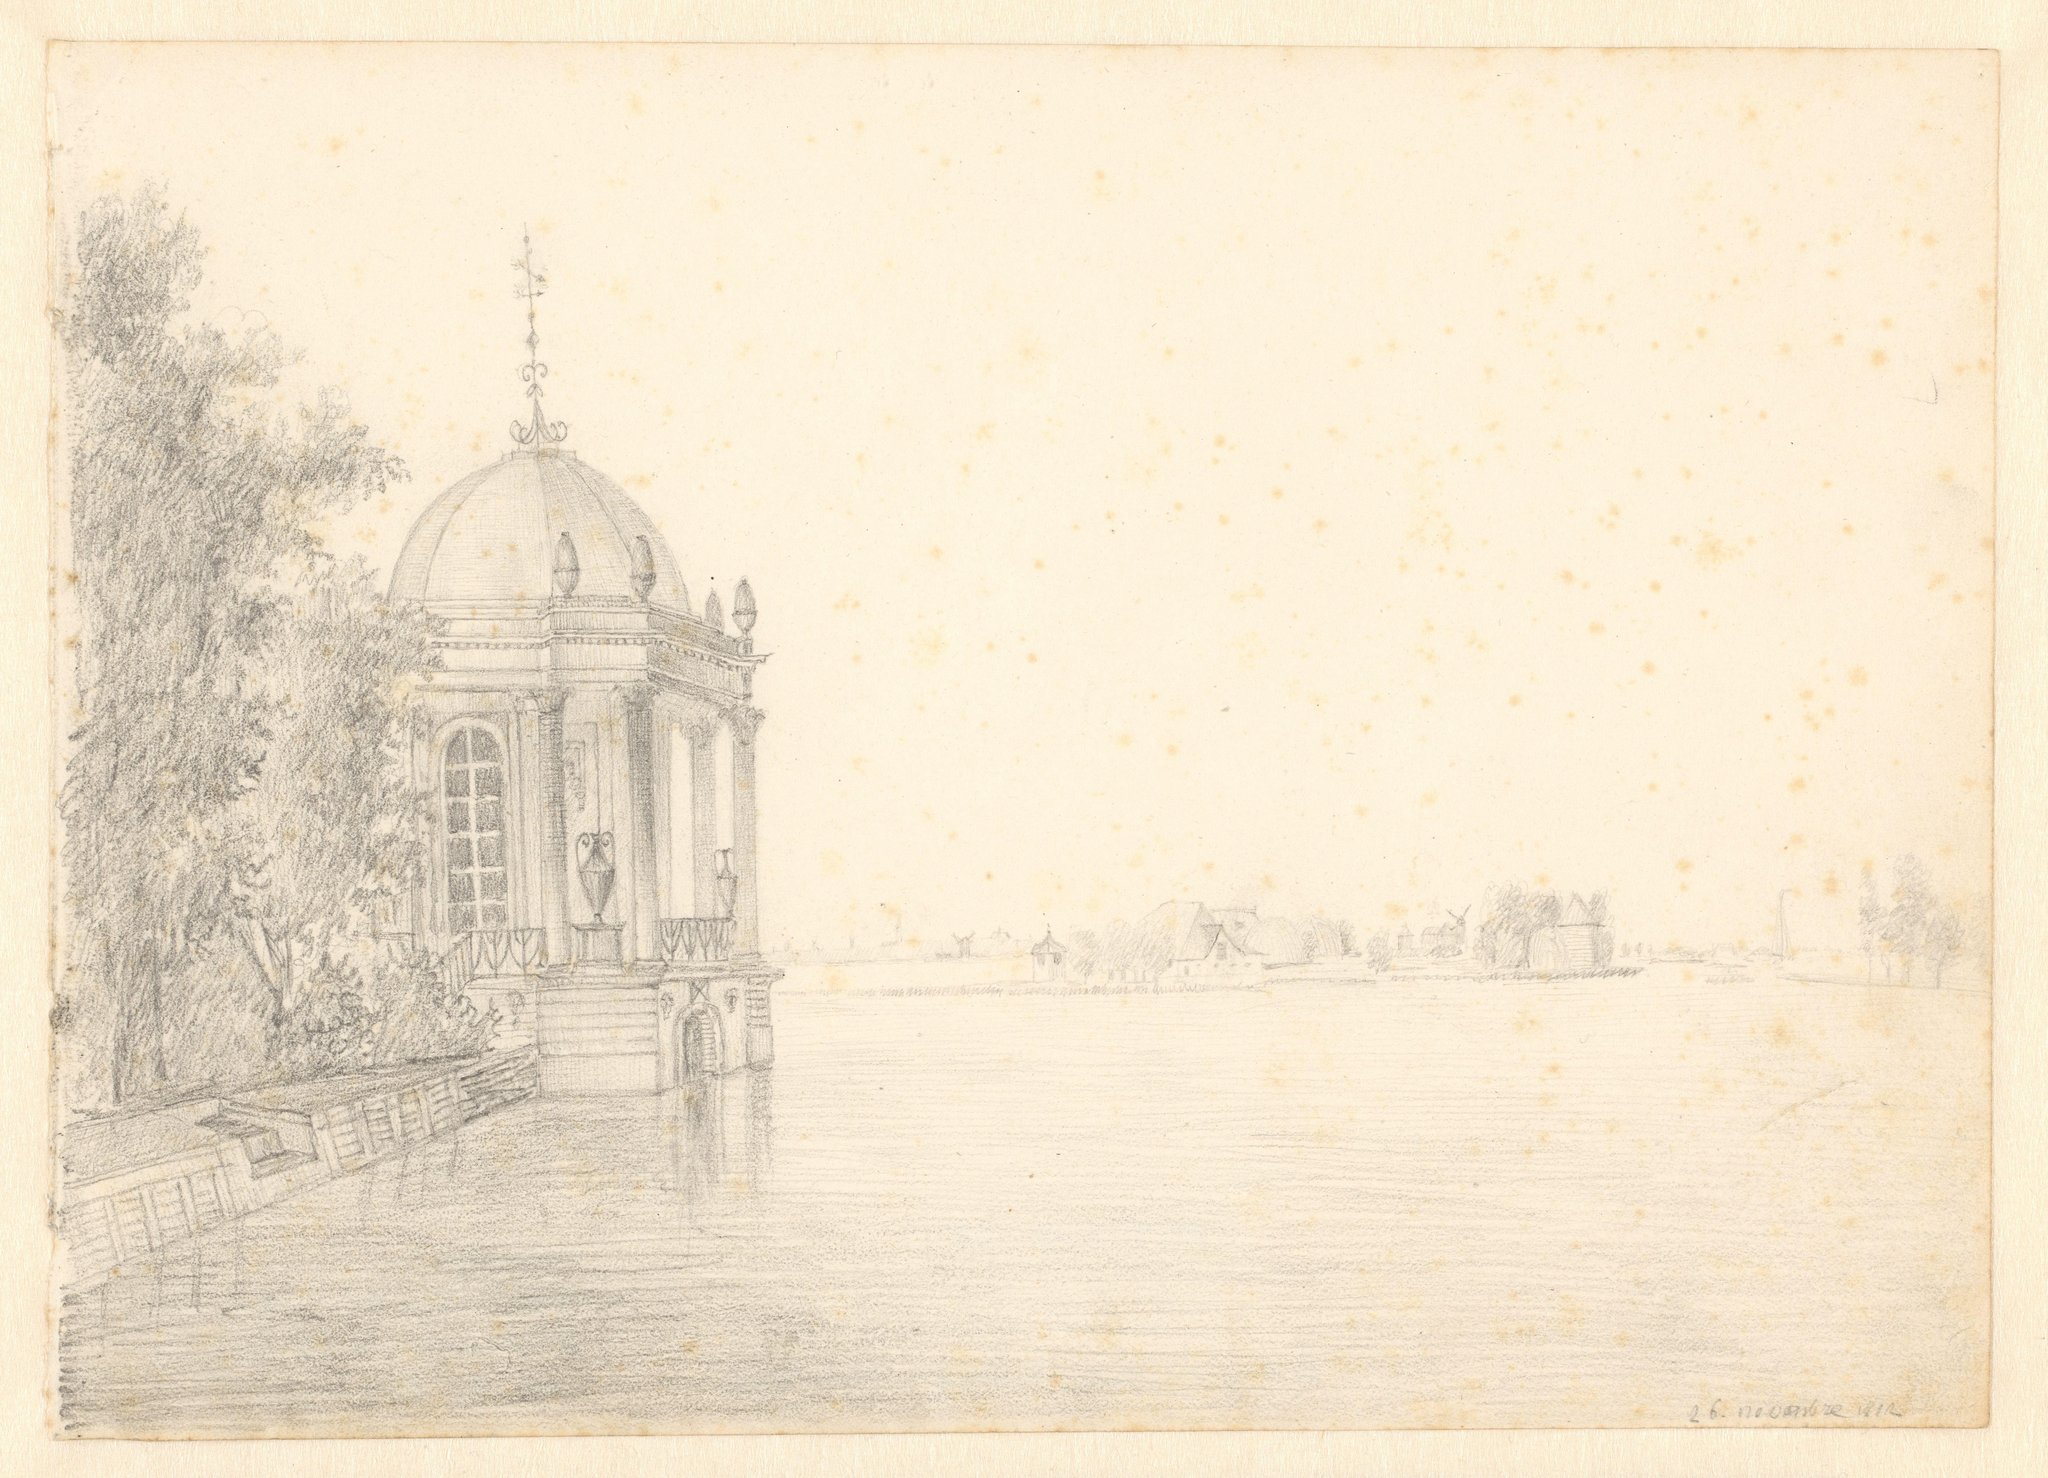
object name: drawing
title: Gezicht op Broek in Waterland met links de koepel van Bakker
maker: adèle clerget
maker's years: 1799-1841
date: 1812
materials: paper, pencil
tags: broek in waterland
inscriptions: date: ‘26. novembre 1812’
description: Detail naar het linker gedeelte van de tekening RP-T-2015-24 door Antoine Ignace Melling (Adèle's vader).